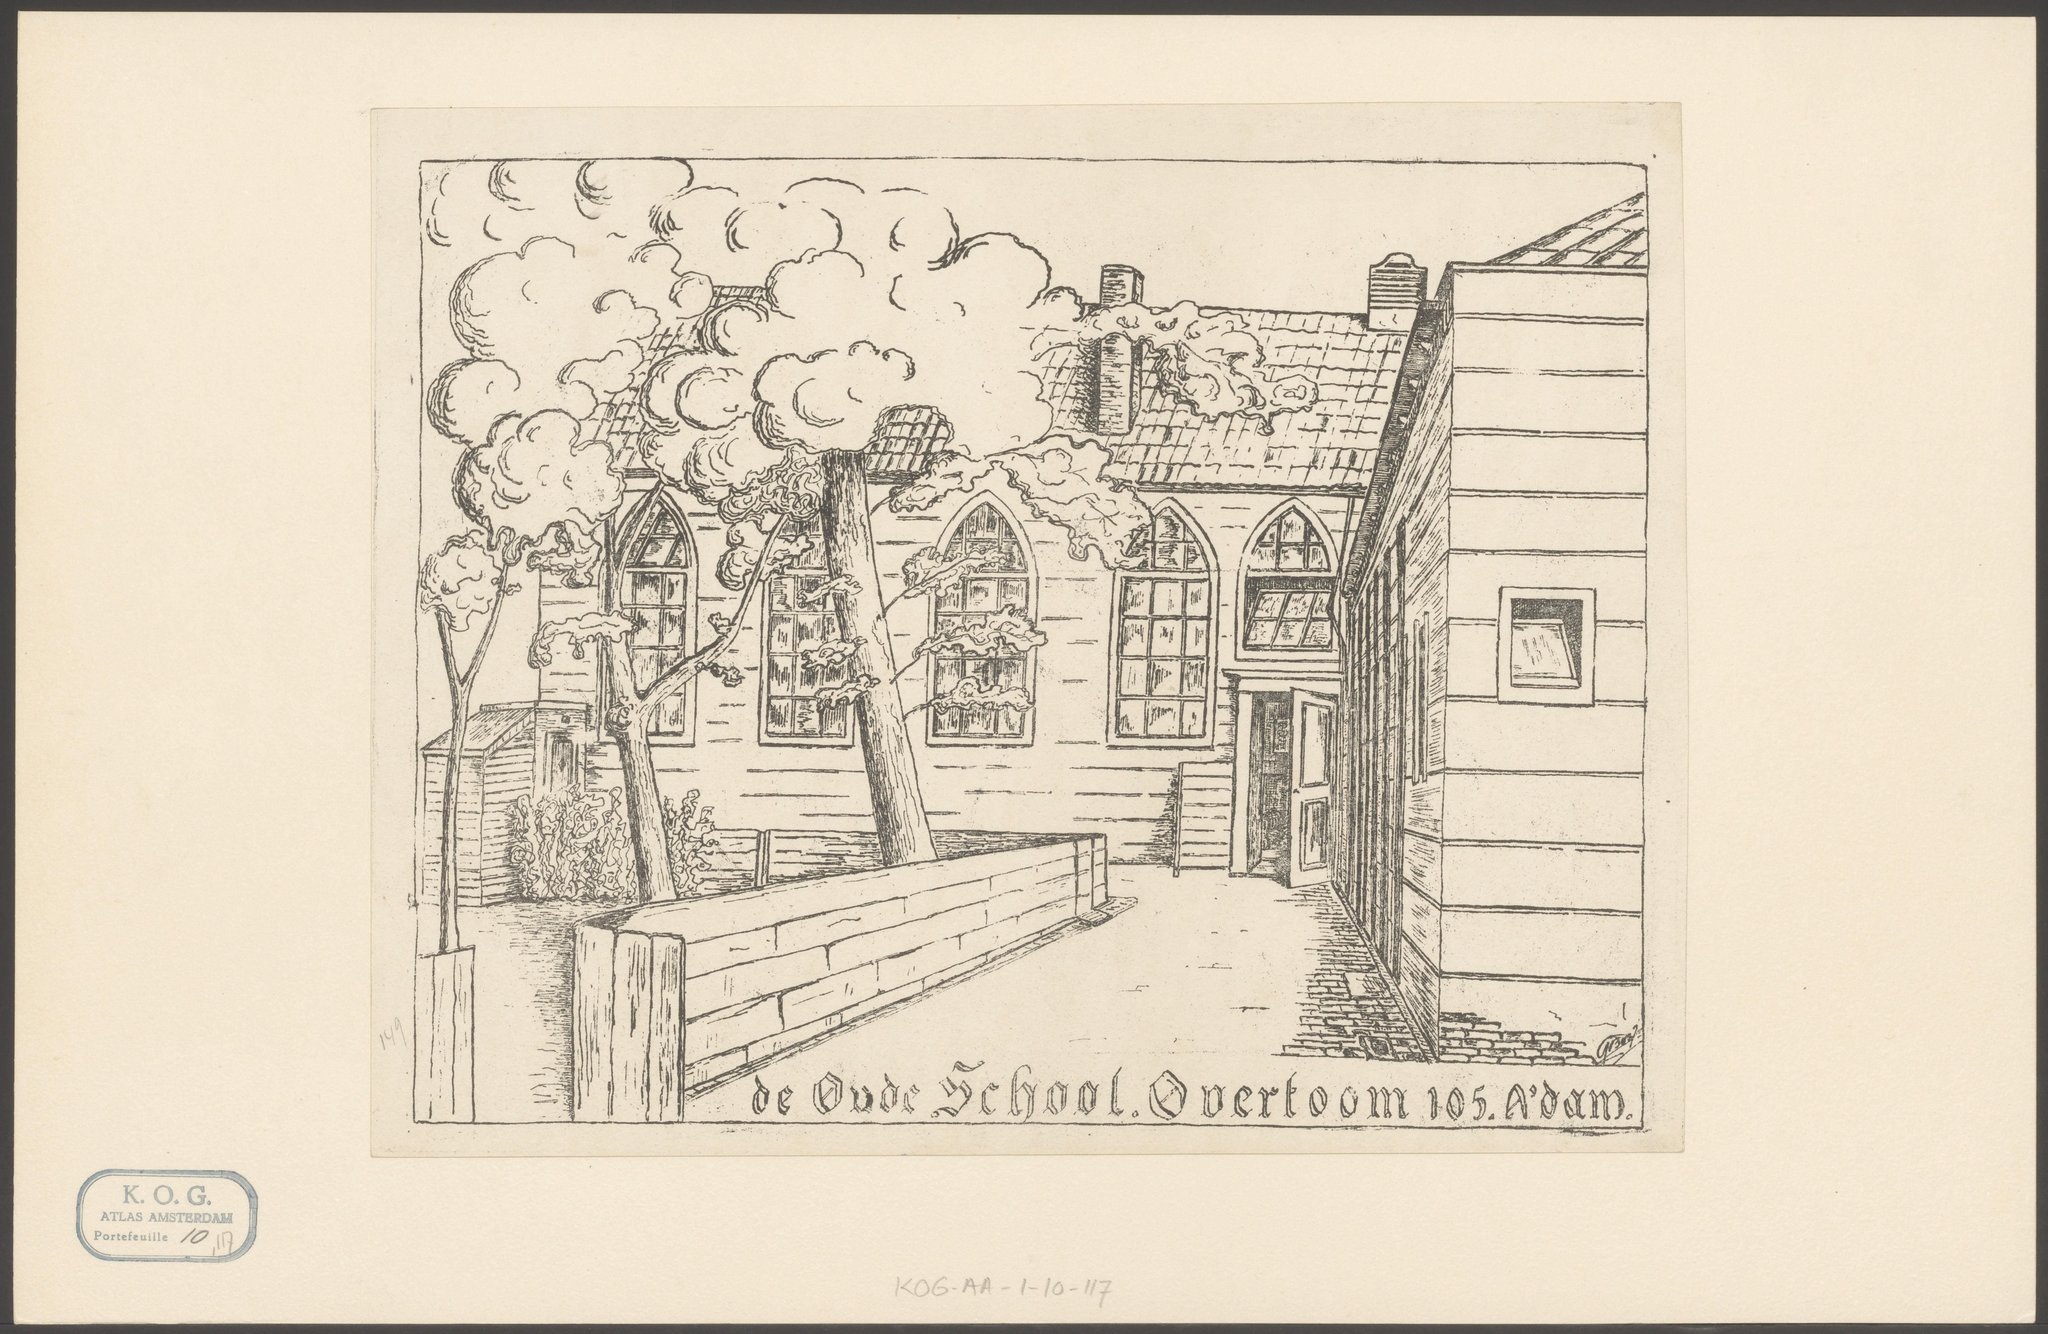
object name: photomechanical print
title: Gezicht op de oude school aan de Overtoom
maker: Anonymous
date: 1928-1983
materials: paper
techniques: line block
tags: city-view in general; 'veduta', elementary school; class, form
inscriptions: collector's mark: ‘10,117’ Lugt 1641b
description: Onderwerpsrubriek binnen de Atlas Amsterdam: Overtoom.